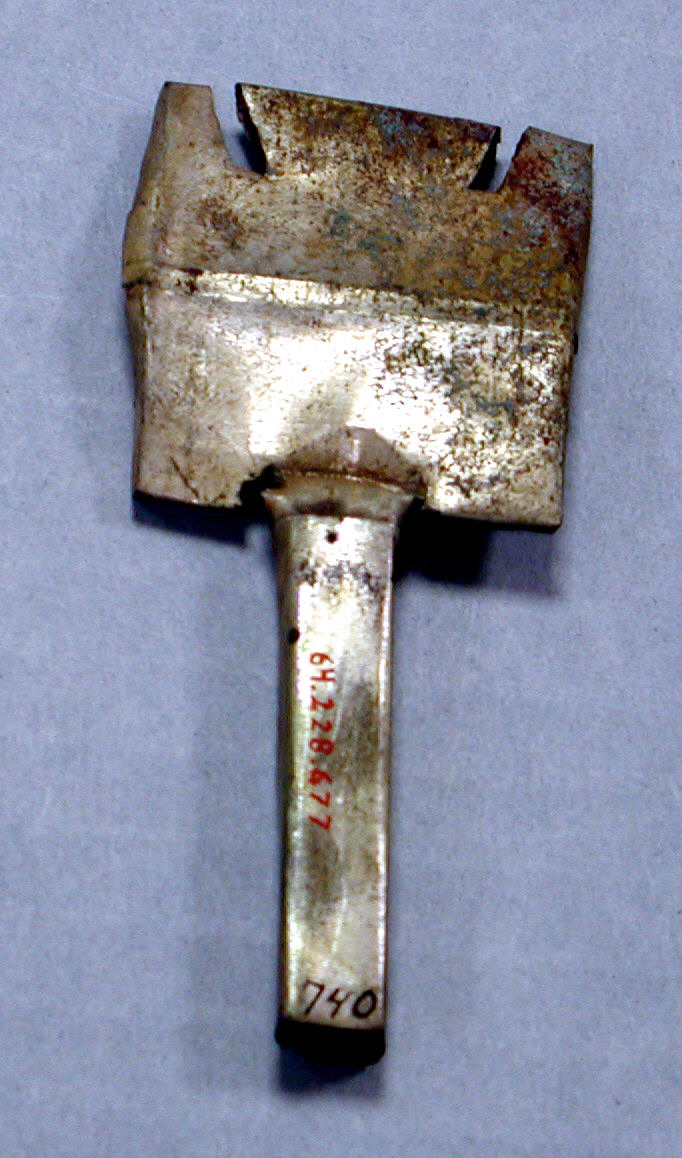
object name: mirror back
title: Hammered Silver Mirror Back (?)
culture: peruvian, north or central coast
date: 1001-1566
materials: gilt, silver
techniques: hammering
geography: peru